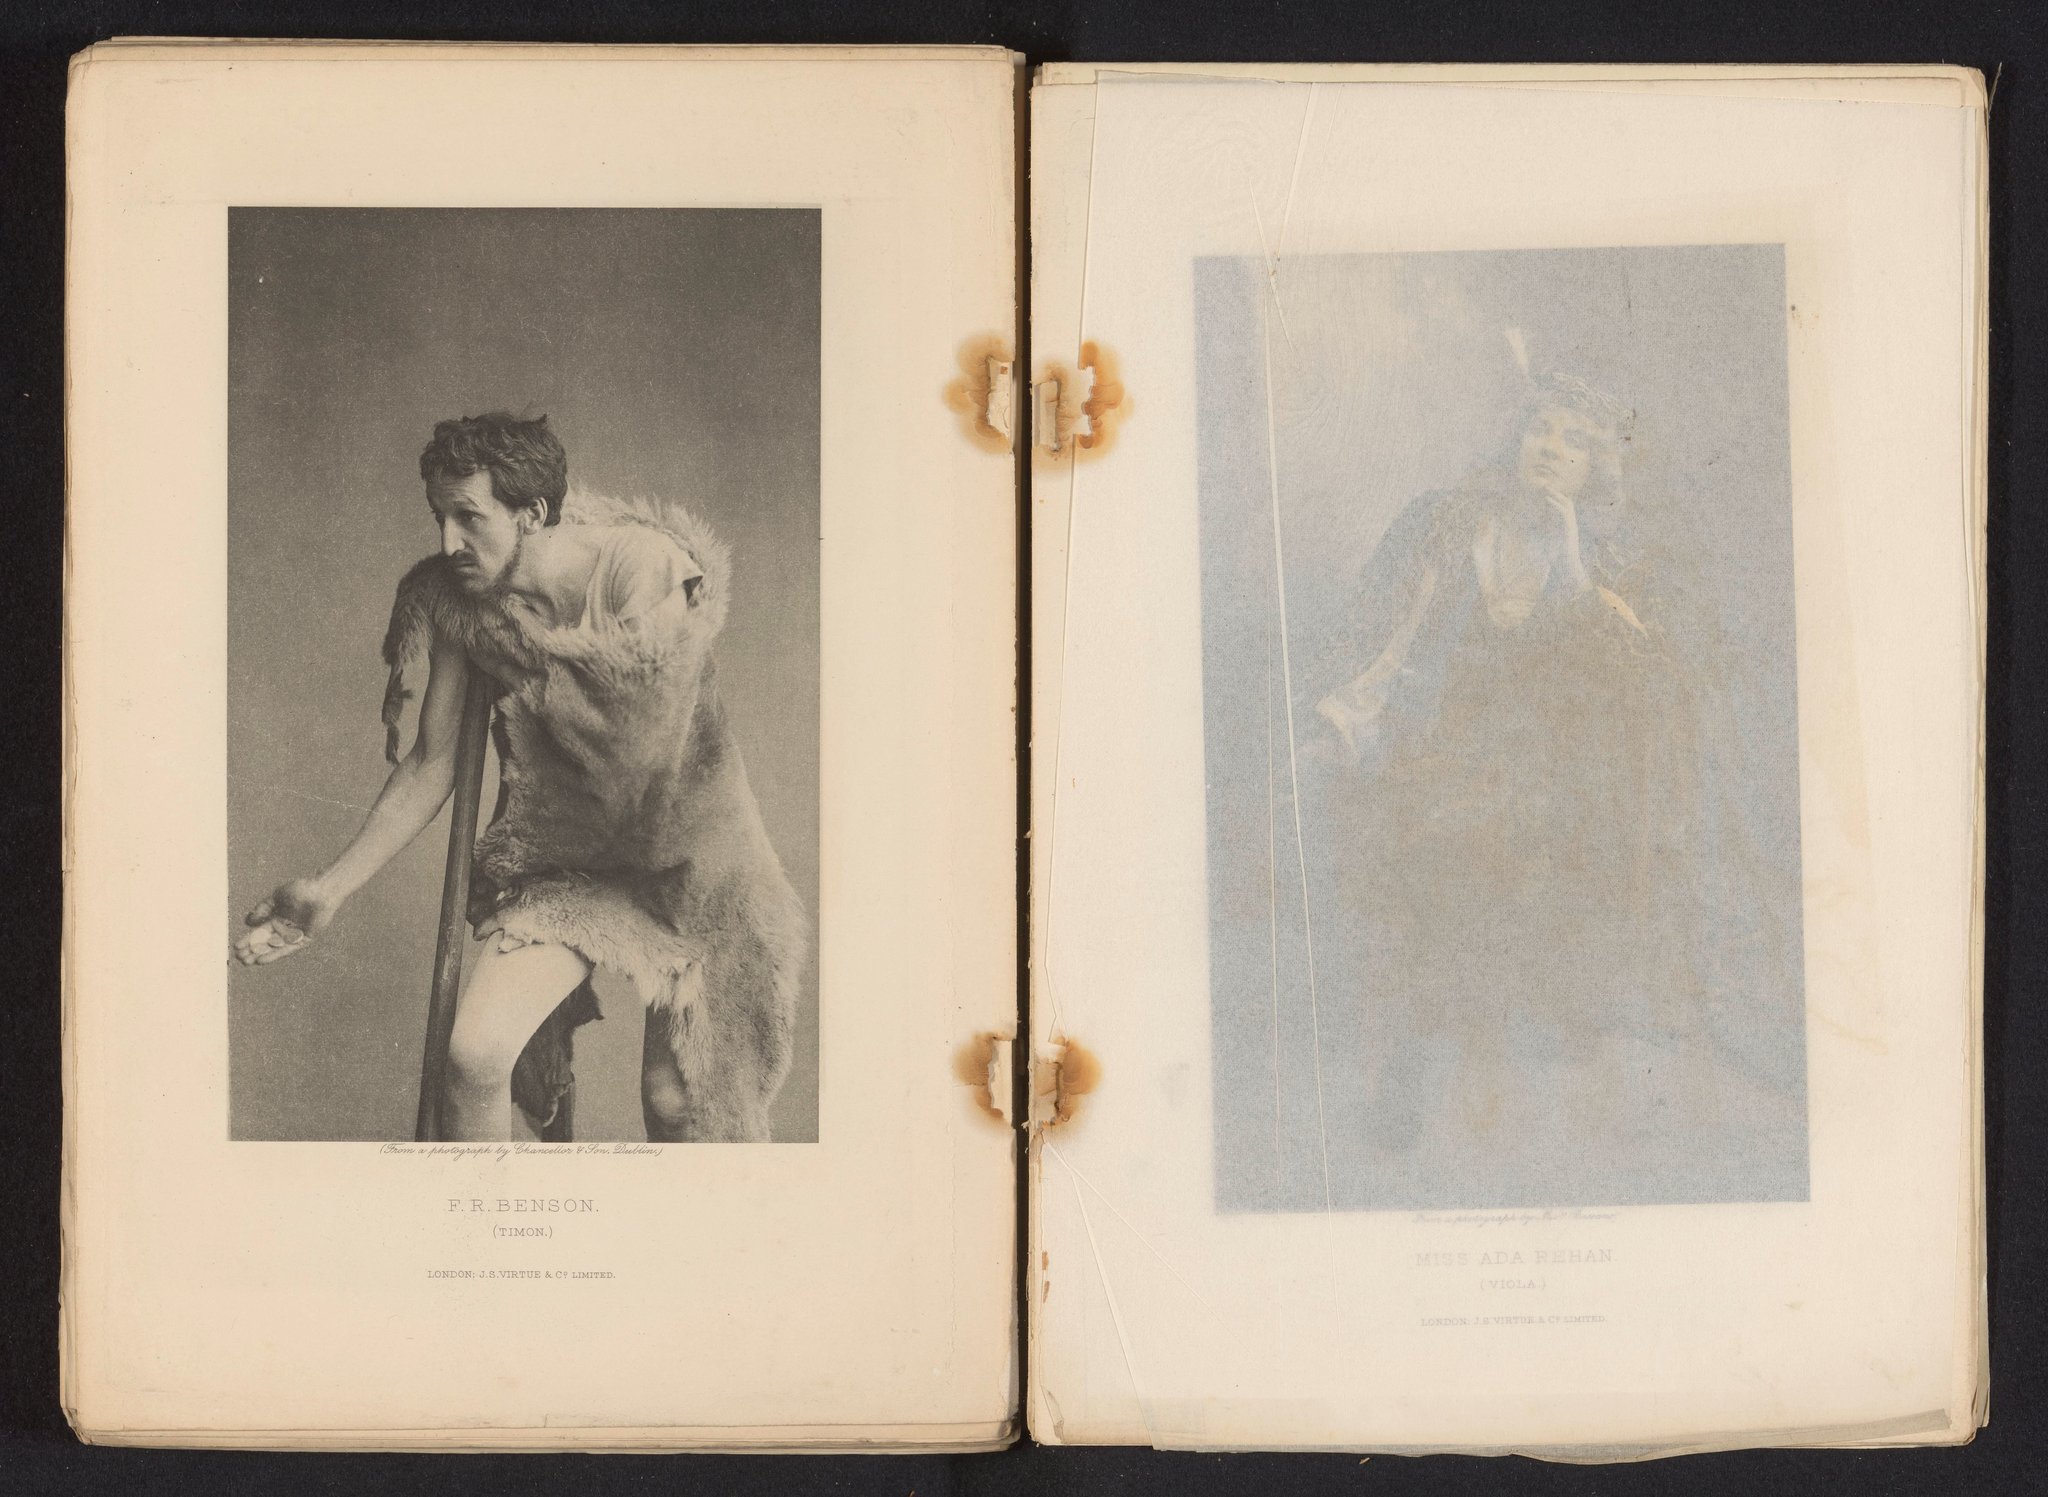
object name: page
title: F.R. Benson (Timon)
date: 1880-1890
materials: paper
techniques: photoaquatint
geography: london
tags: portrait of actor, actress